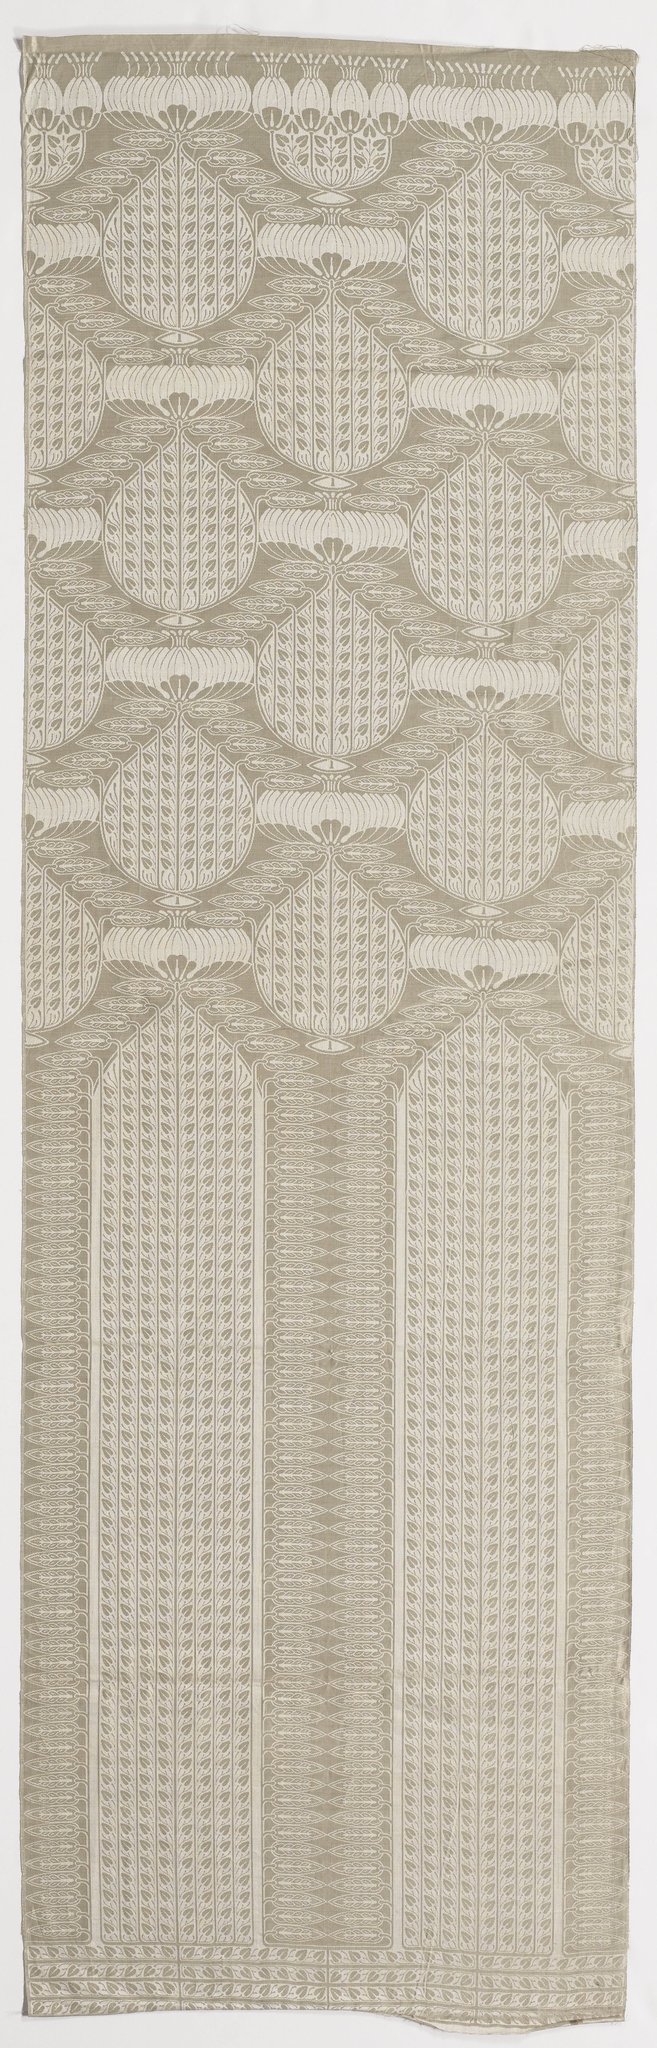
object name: upholstered wall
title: Wandbespanning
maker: chris lebeau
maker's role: draughtsman, print maker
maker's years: 1878-1945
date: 1911-1915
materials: linen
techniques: damask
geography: eindhoven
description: Beige-grijze damasten wandbespanning met een dessin van waterlelies (?).